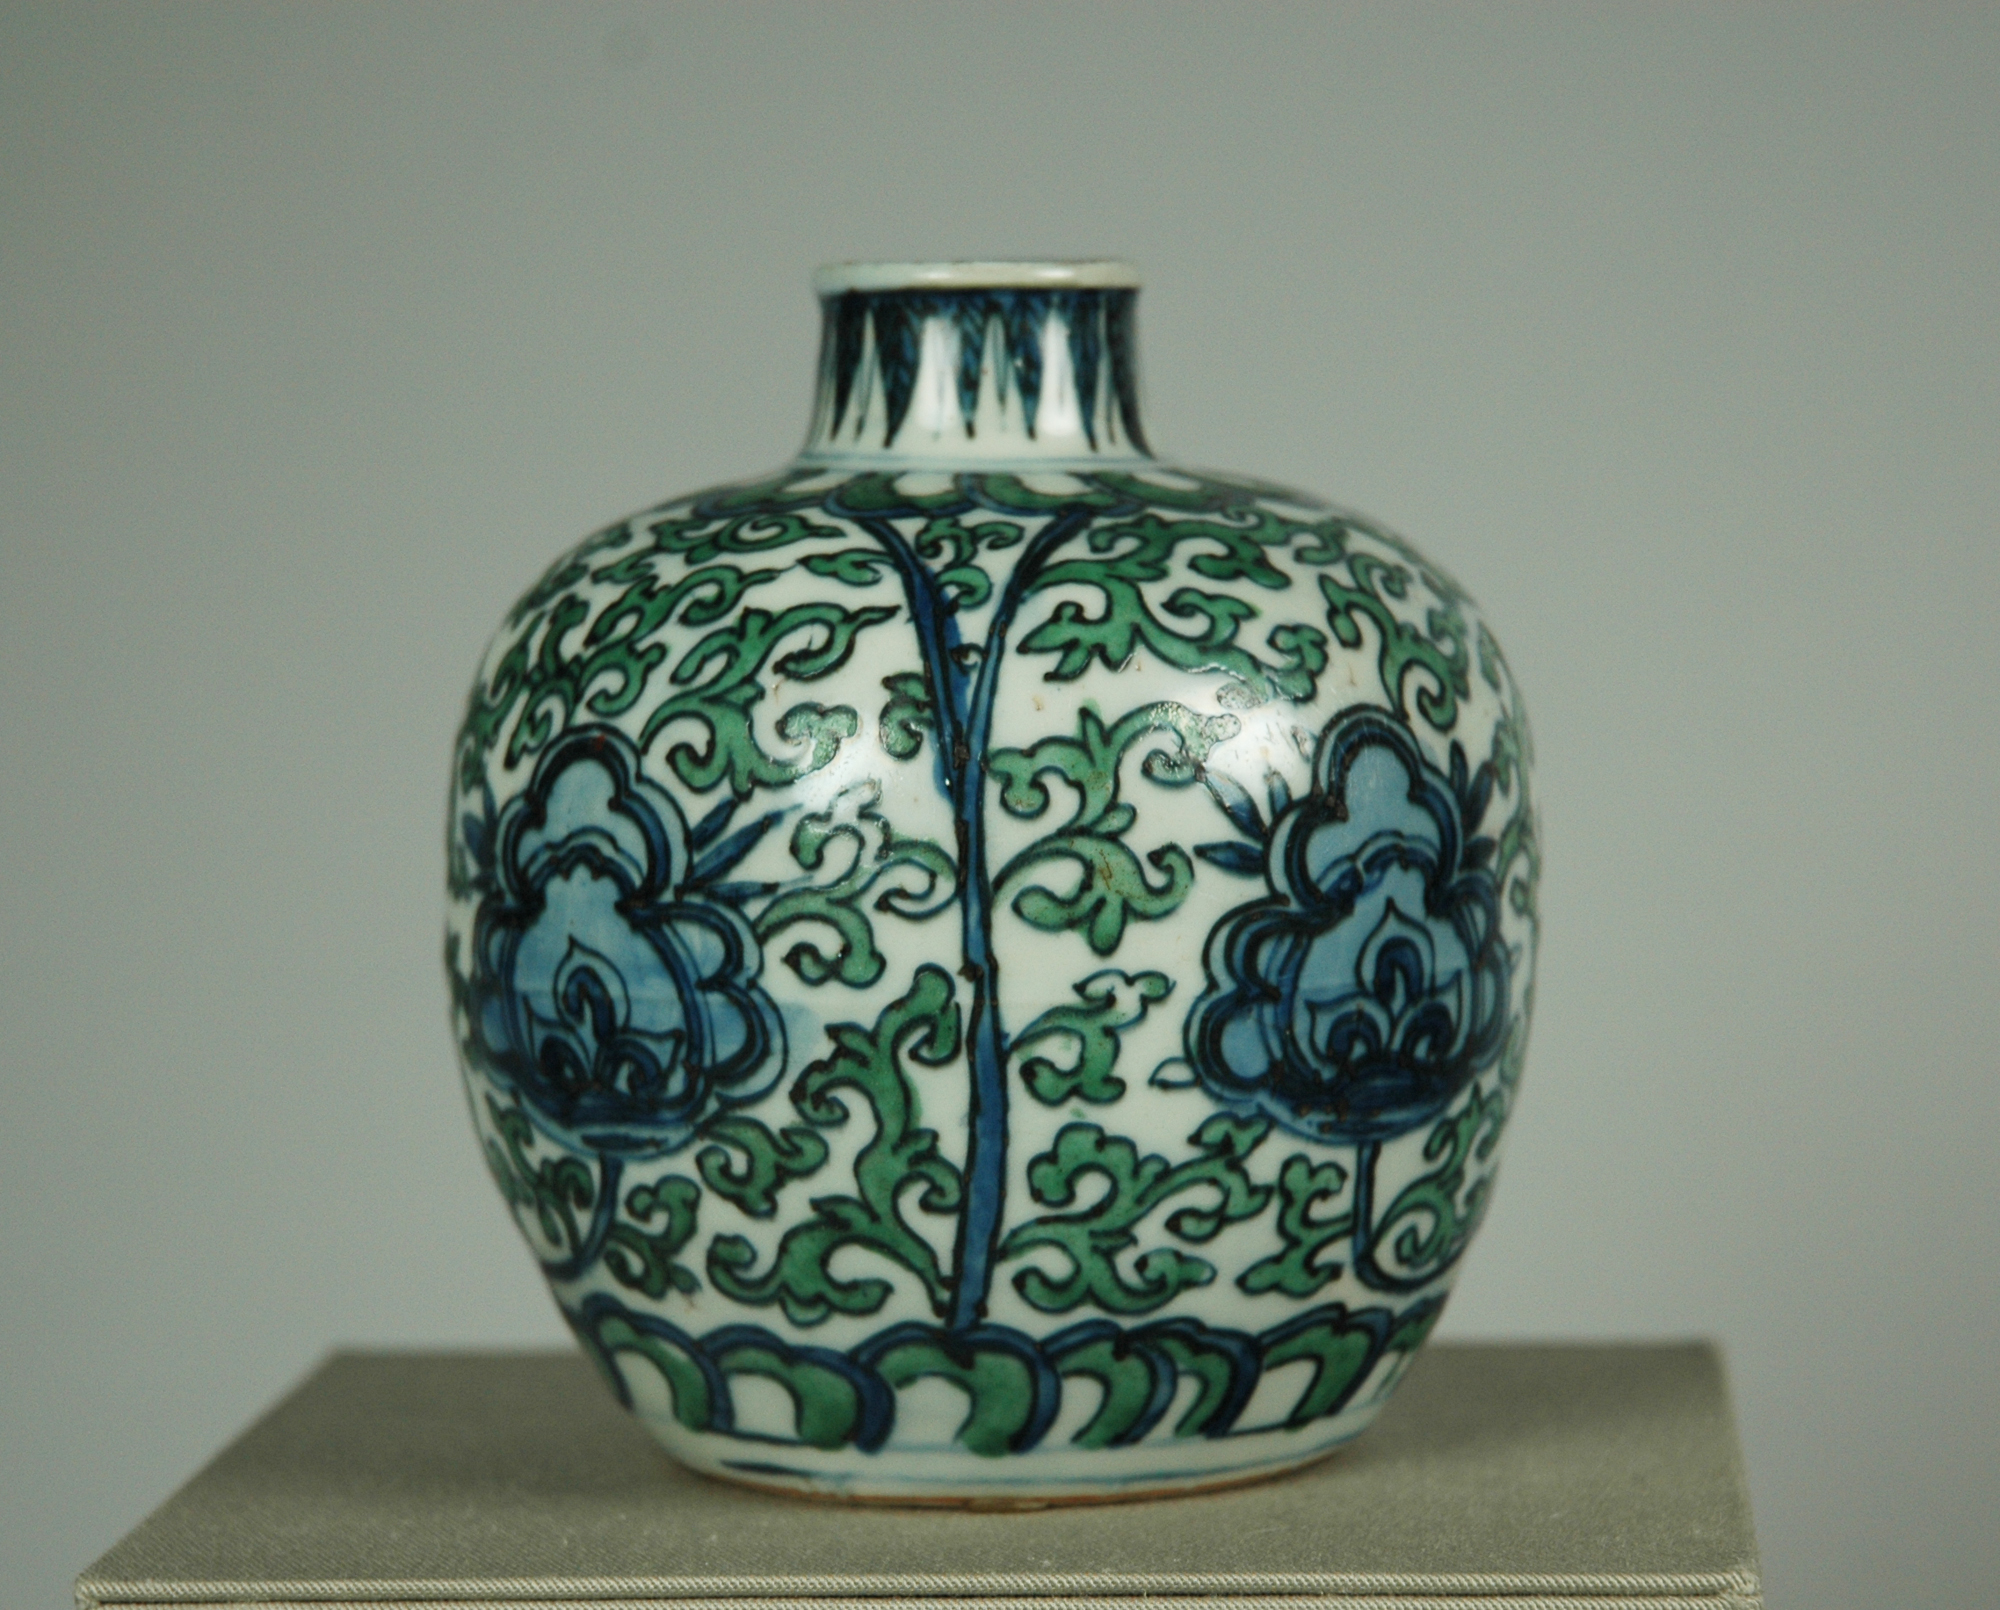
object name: jar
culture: chinese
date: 1573-1620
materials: porcelain